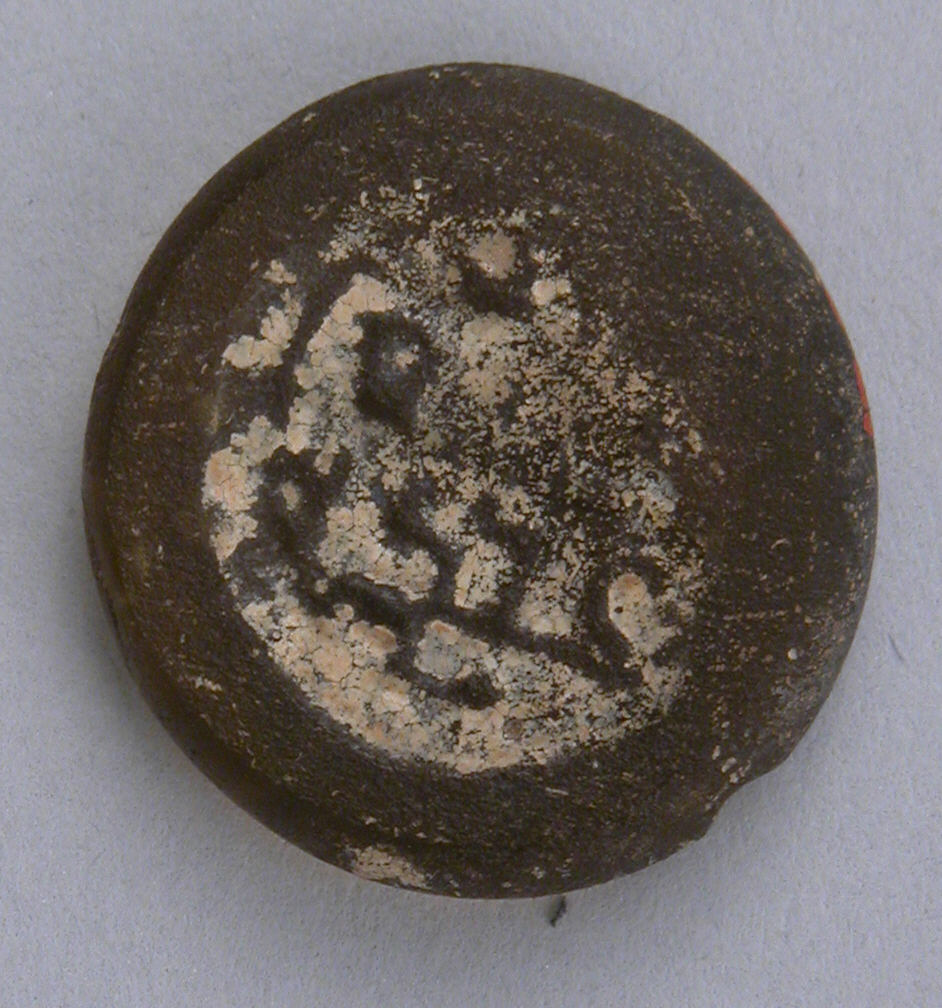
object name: coin weight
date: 901-1100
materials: glass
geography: egypt